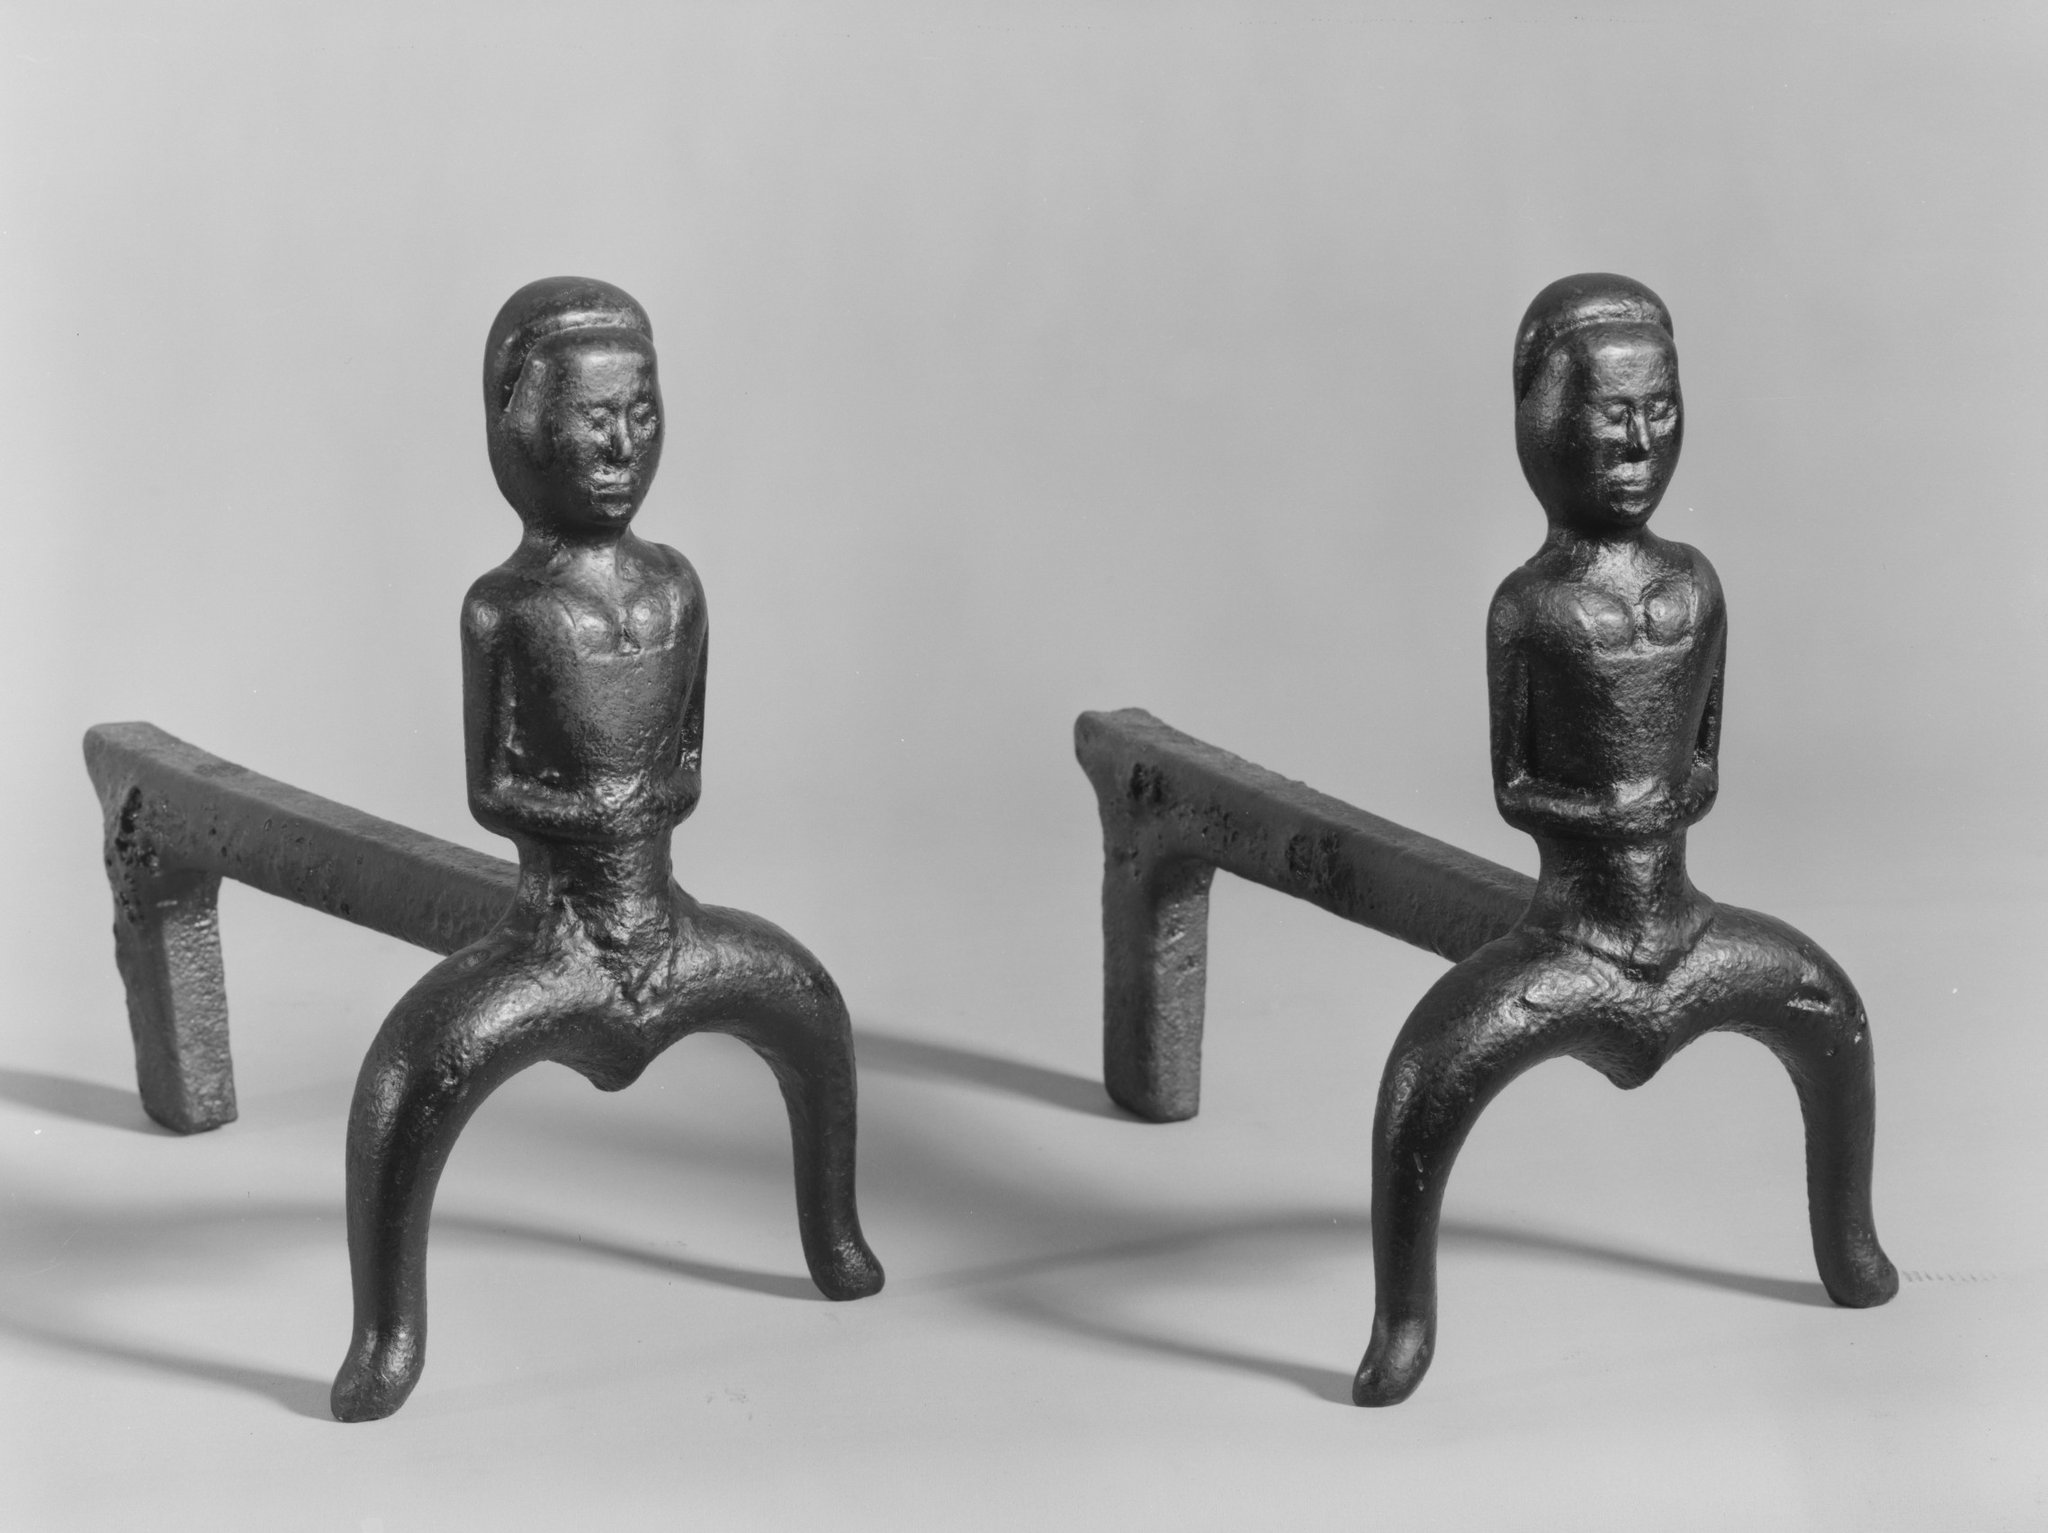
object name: andiron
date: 1770-1800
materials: iron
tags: human figures